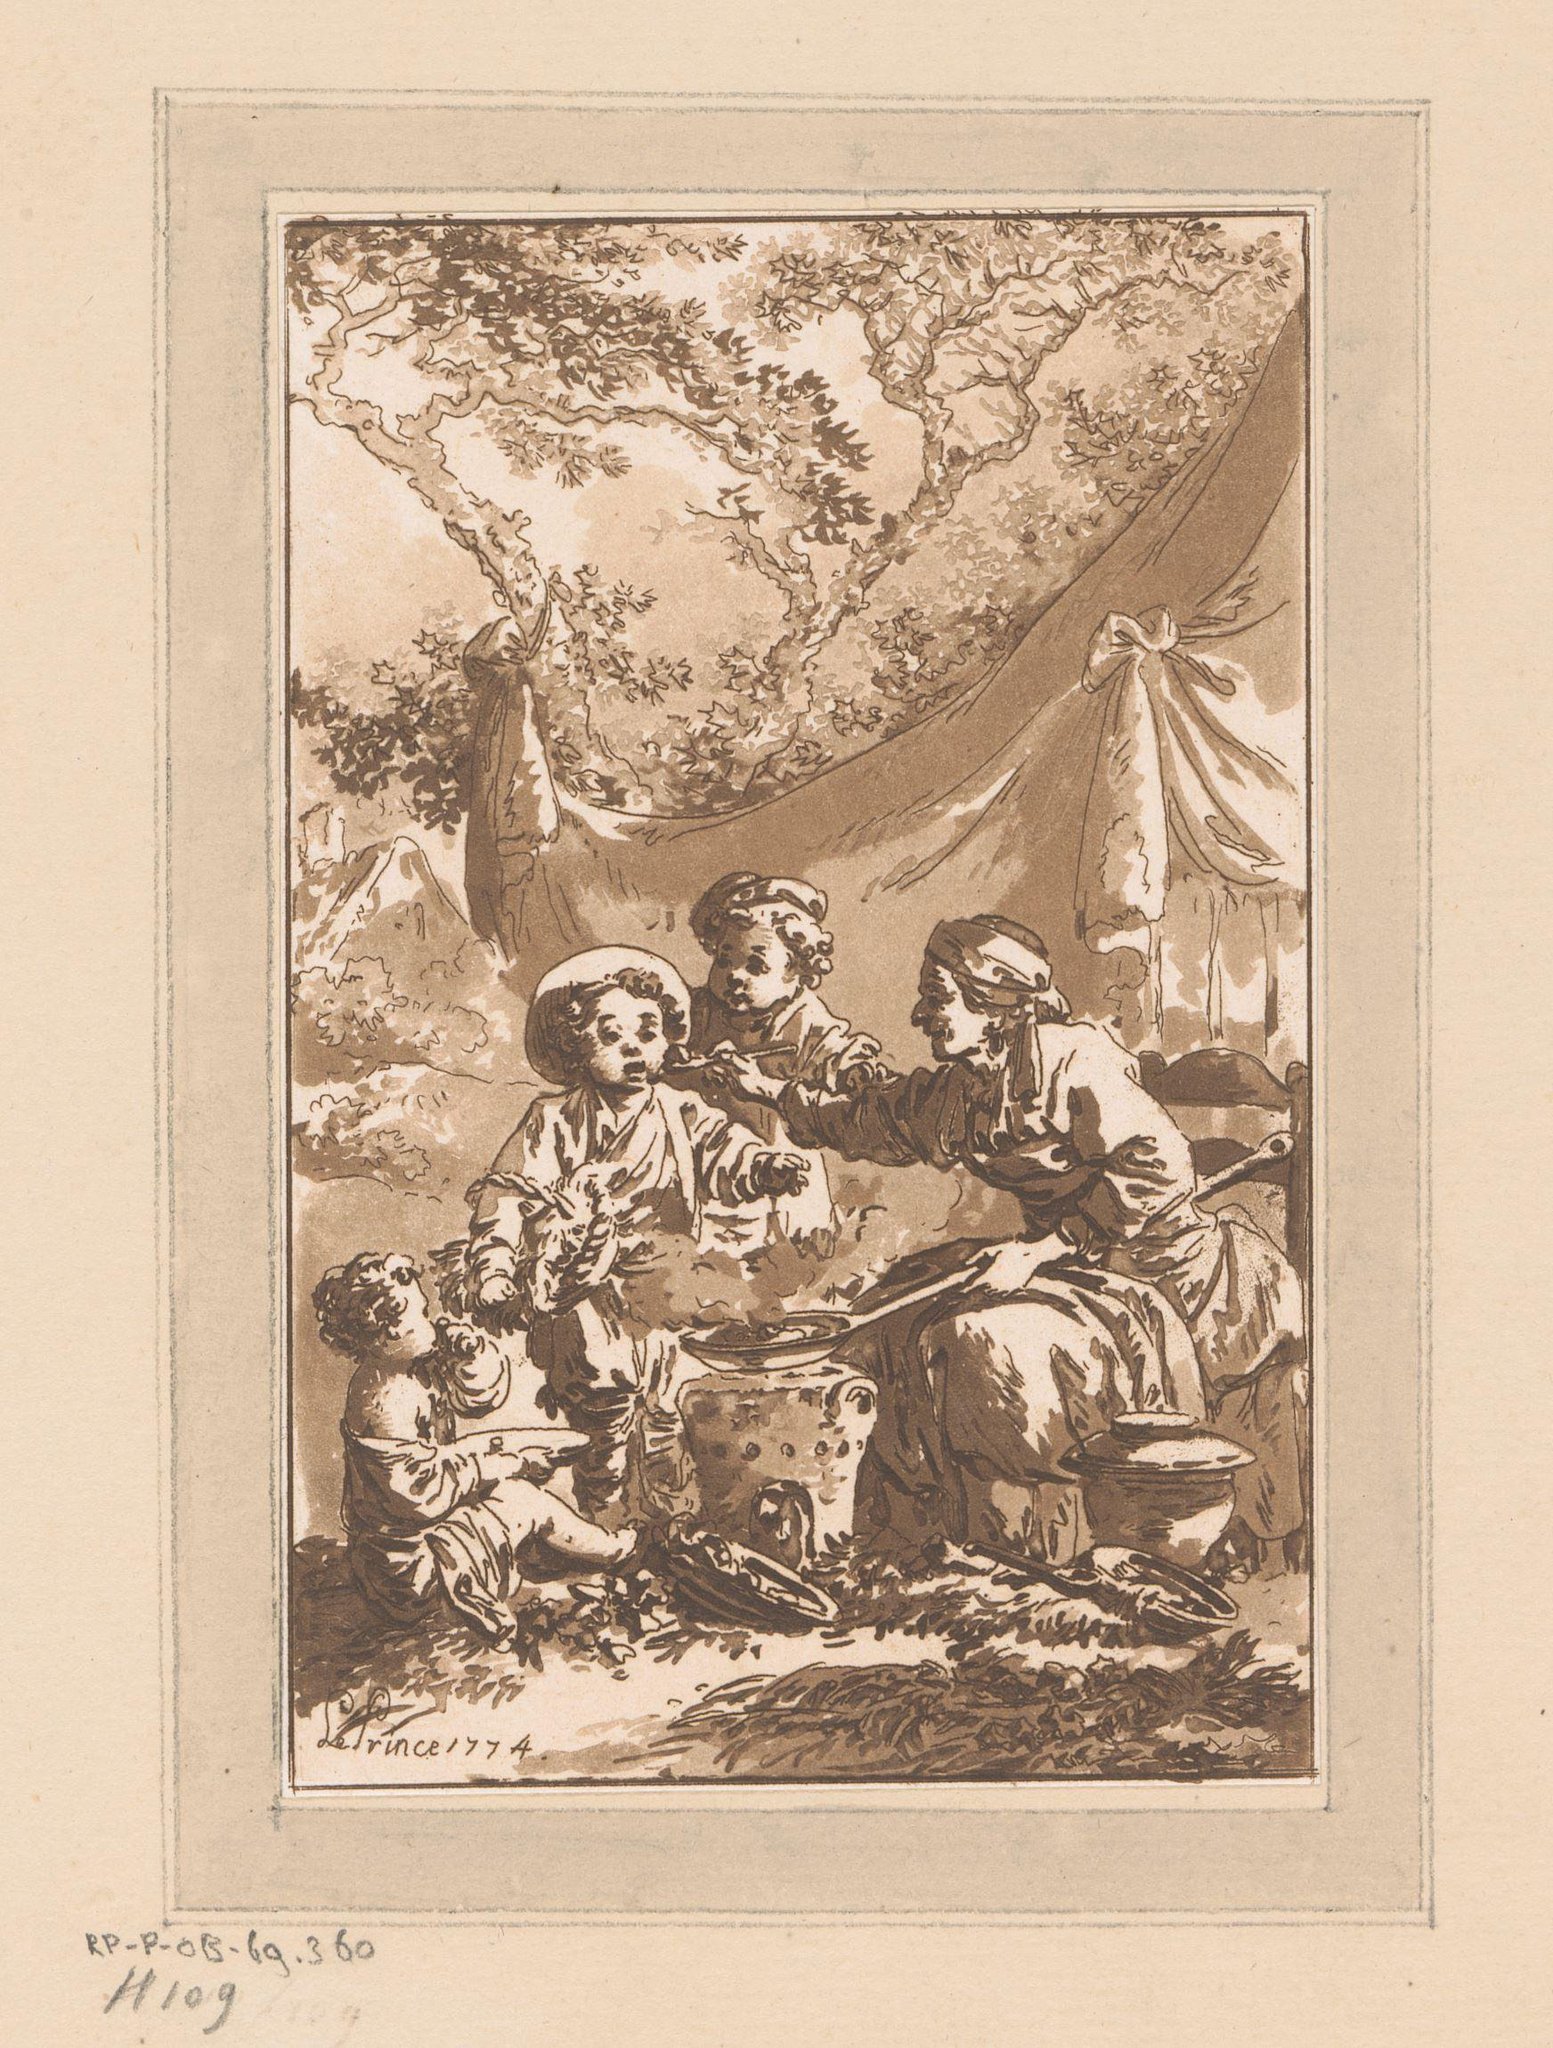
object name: print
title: De vijf zintuigen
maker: jean baptist leprince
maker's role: draughtsman, print maker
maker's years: 1734-1781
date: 1774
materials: paper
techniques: aquatint, etching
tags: taste, tasting (one of the five senses), cooking food - cc - in the open air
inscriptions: date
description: Maakt deel uit van een vijfdelige serie met de zintuigen.